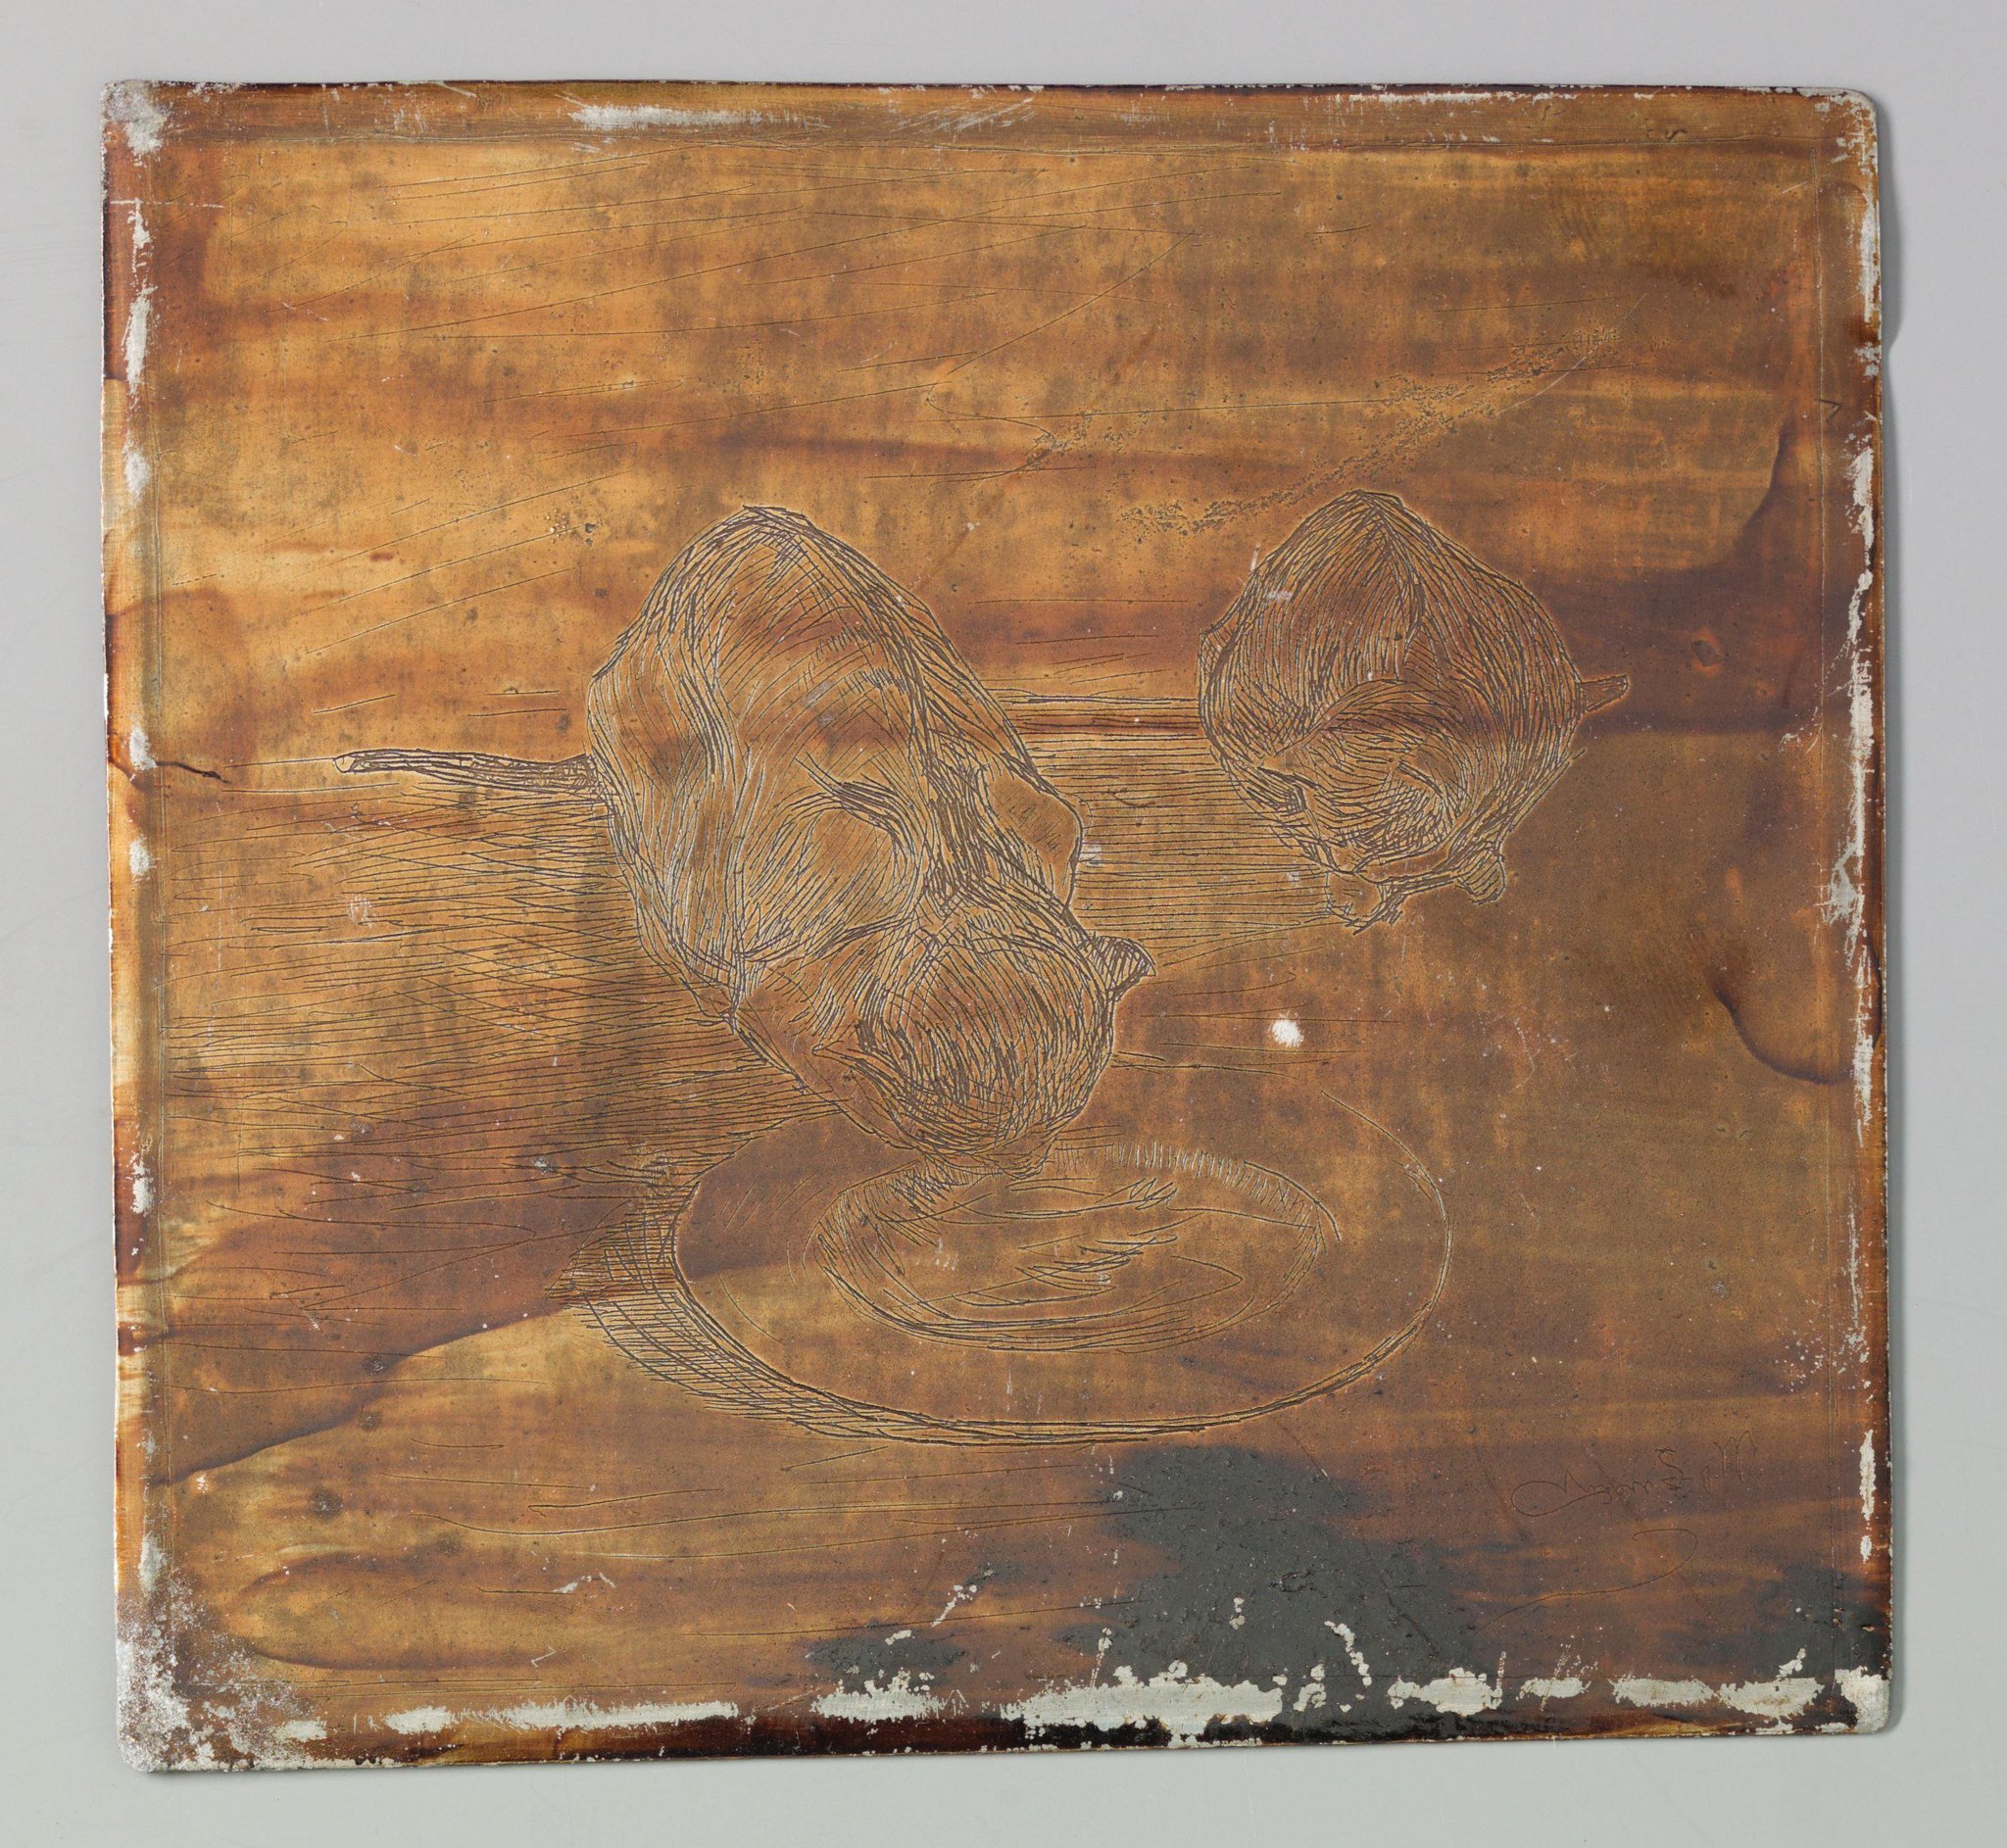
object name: zinkplaat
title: Twee drinkende katten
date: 1885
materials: zinc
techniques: etching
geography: netherlands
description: Etsplaat van zink voor de ets 'Twee drinkende katten', ca. 1885.